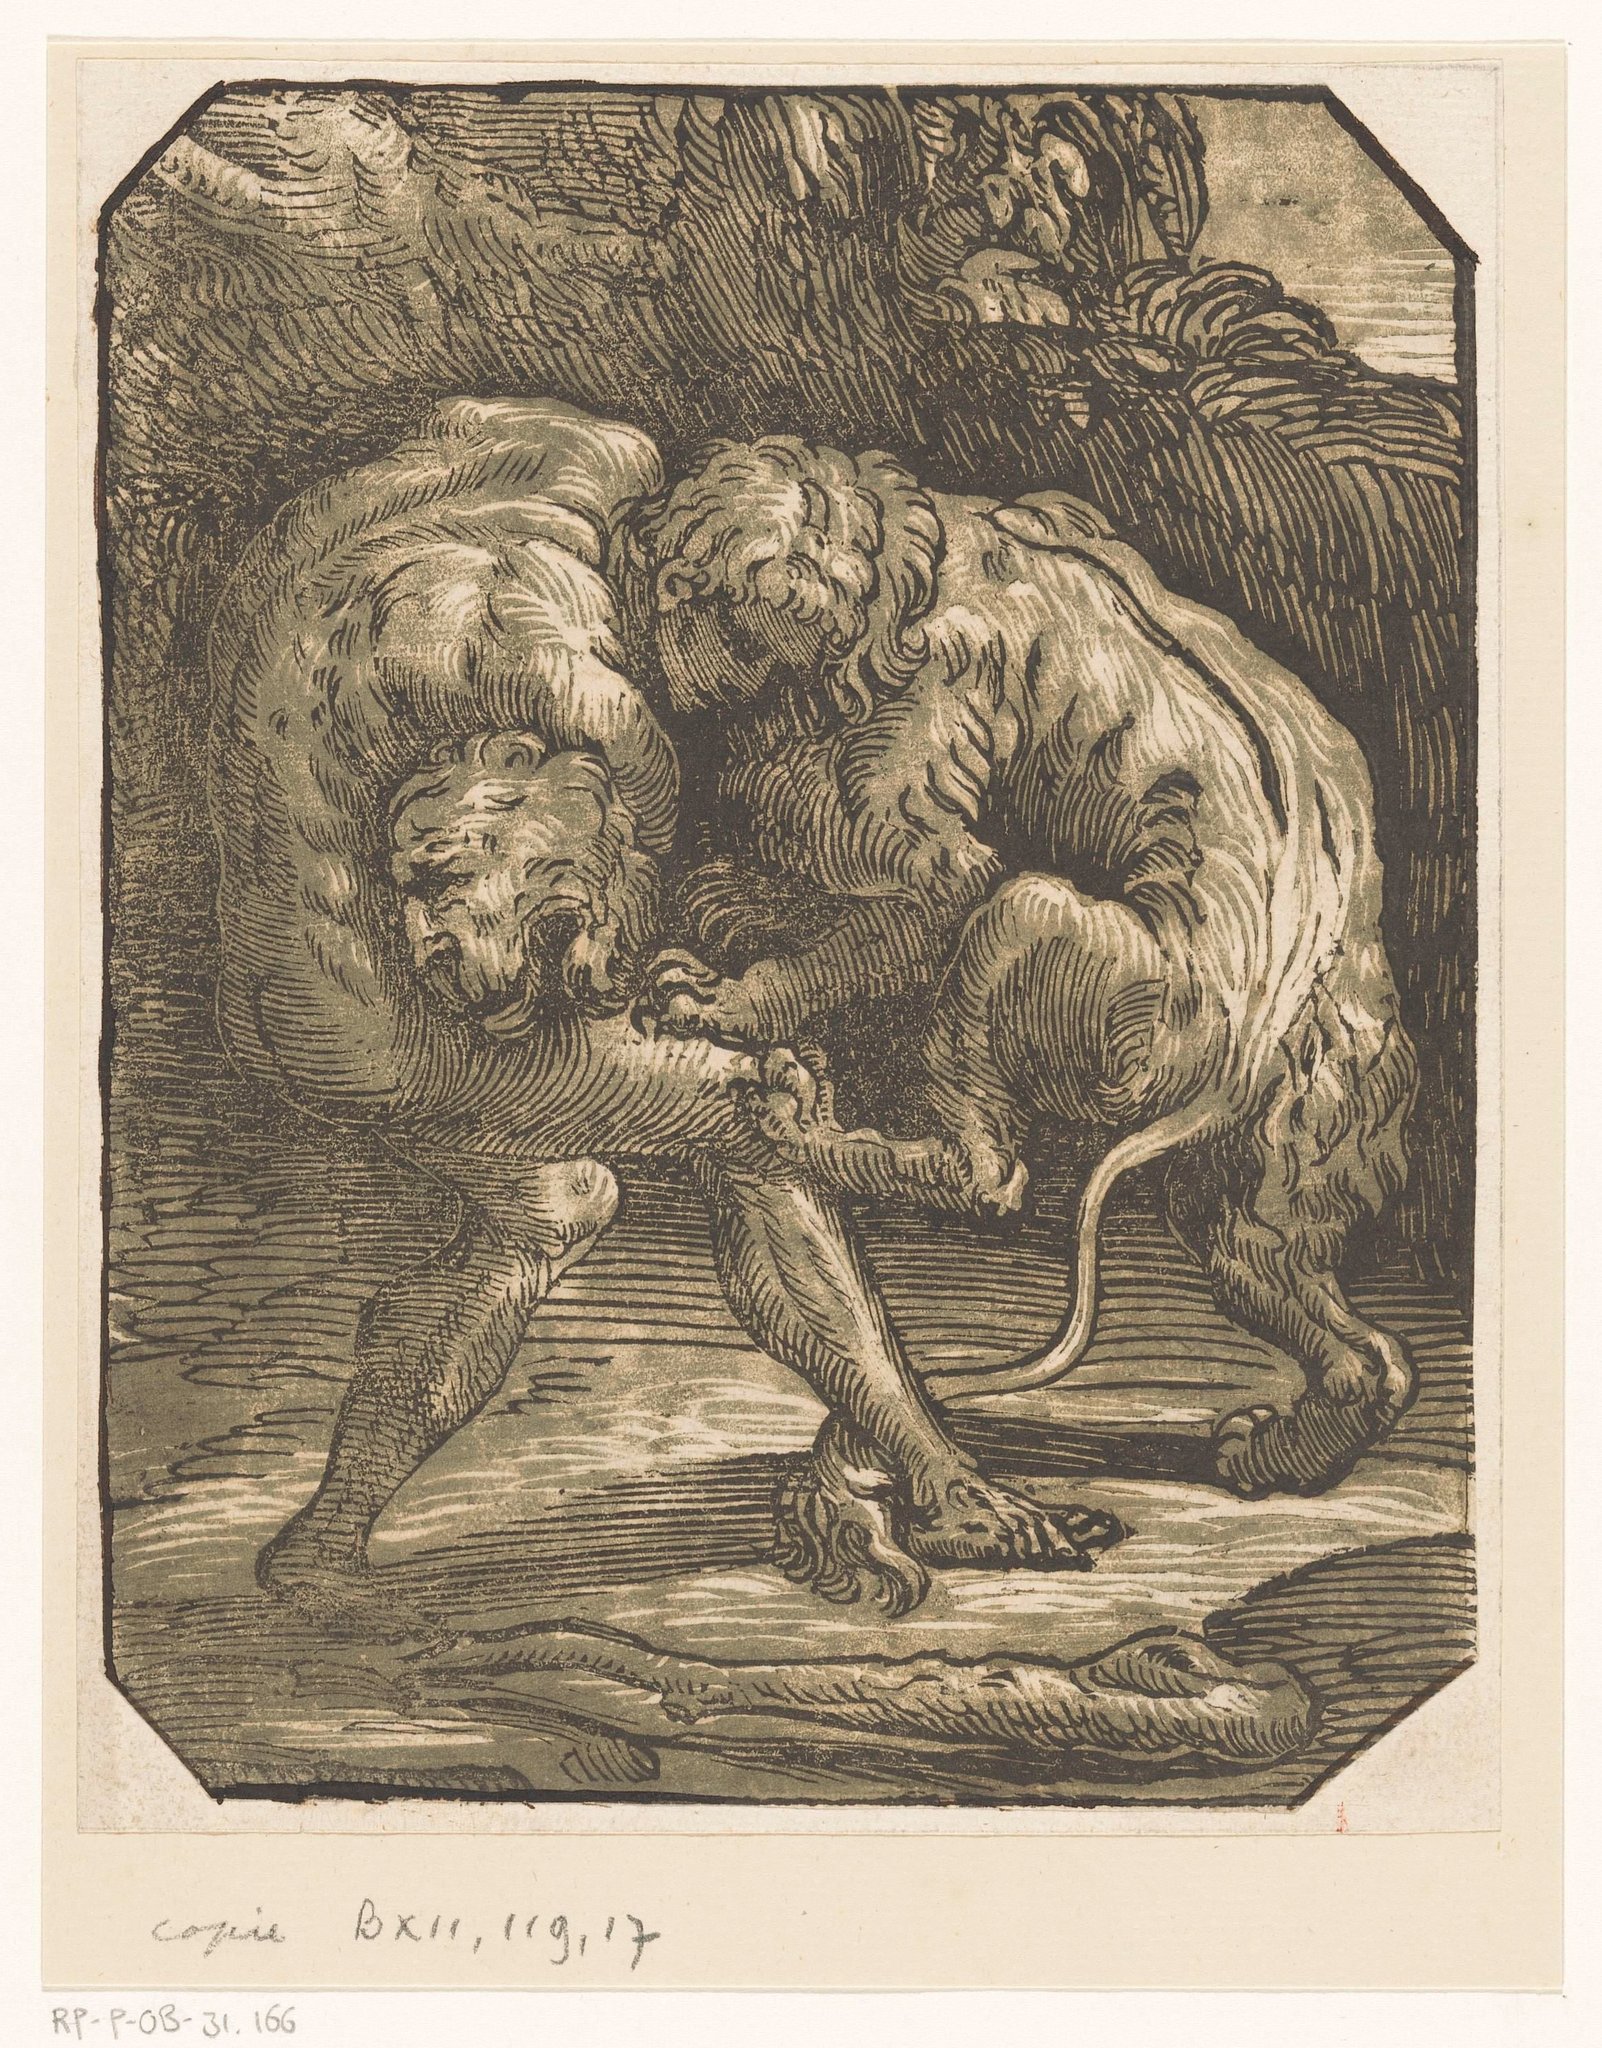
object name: print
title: Hercules en de Nemeïsche leeuw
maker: Anonymous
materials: paper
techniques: woodcut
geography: italy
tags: (1) hercules chokes the nemean lion with his arms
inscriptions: collector's mark: Lugt 240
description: In een landschap is Hercules in gevecht met de Nemeïsche leeuw. Op de voorgrond de knots van Hercules.